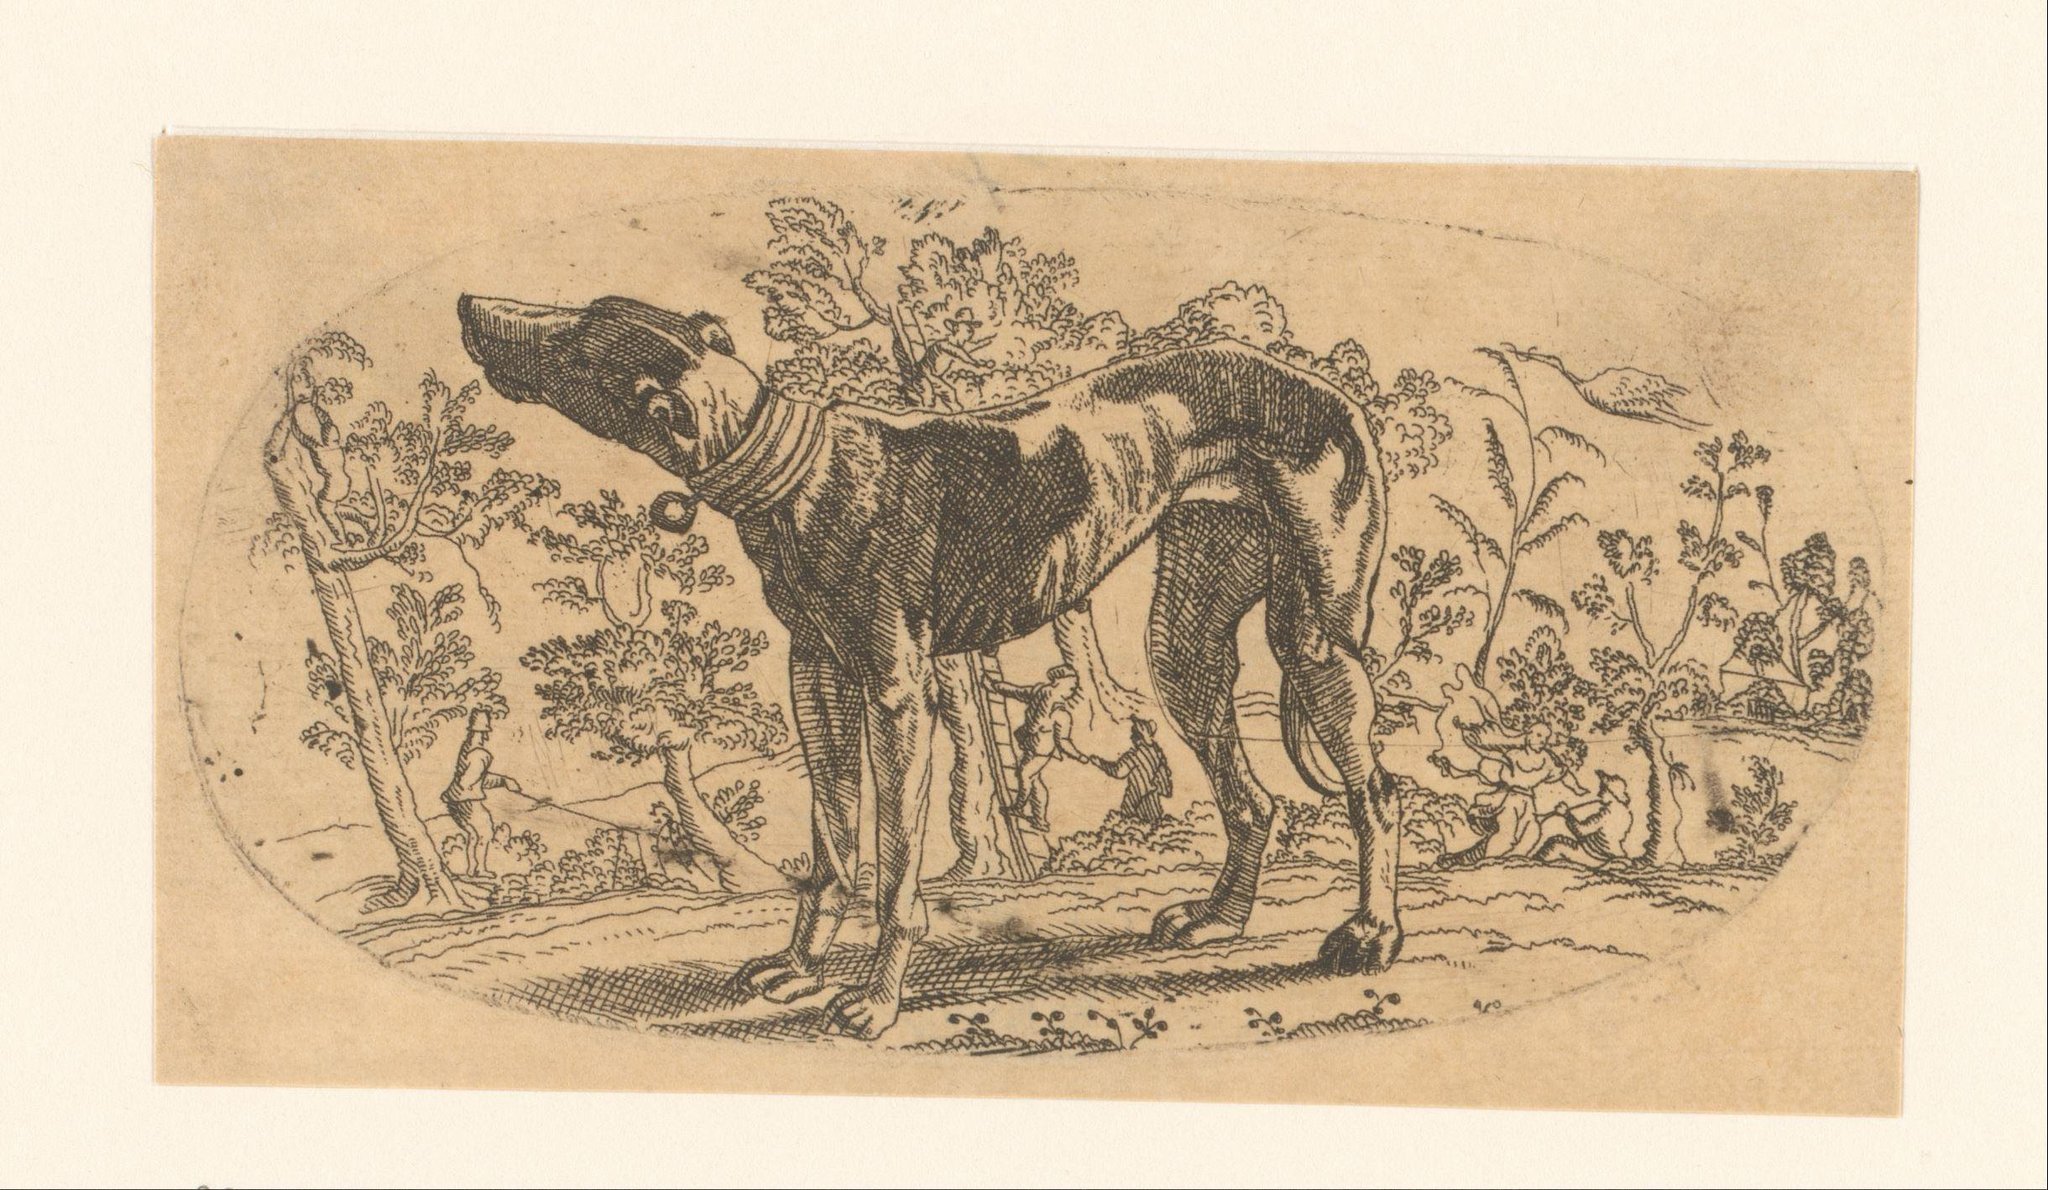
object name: print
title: Staande hond voor een landschap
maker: Anonymous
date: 1636-1699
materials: paper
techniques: etching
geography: northern netherlands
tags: landscapes in the temperate zone, climbing up a tree, dog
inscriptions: collector's mark: Lugt 2228